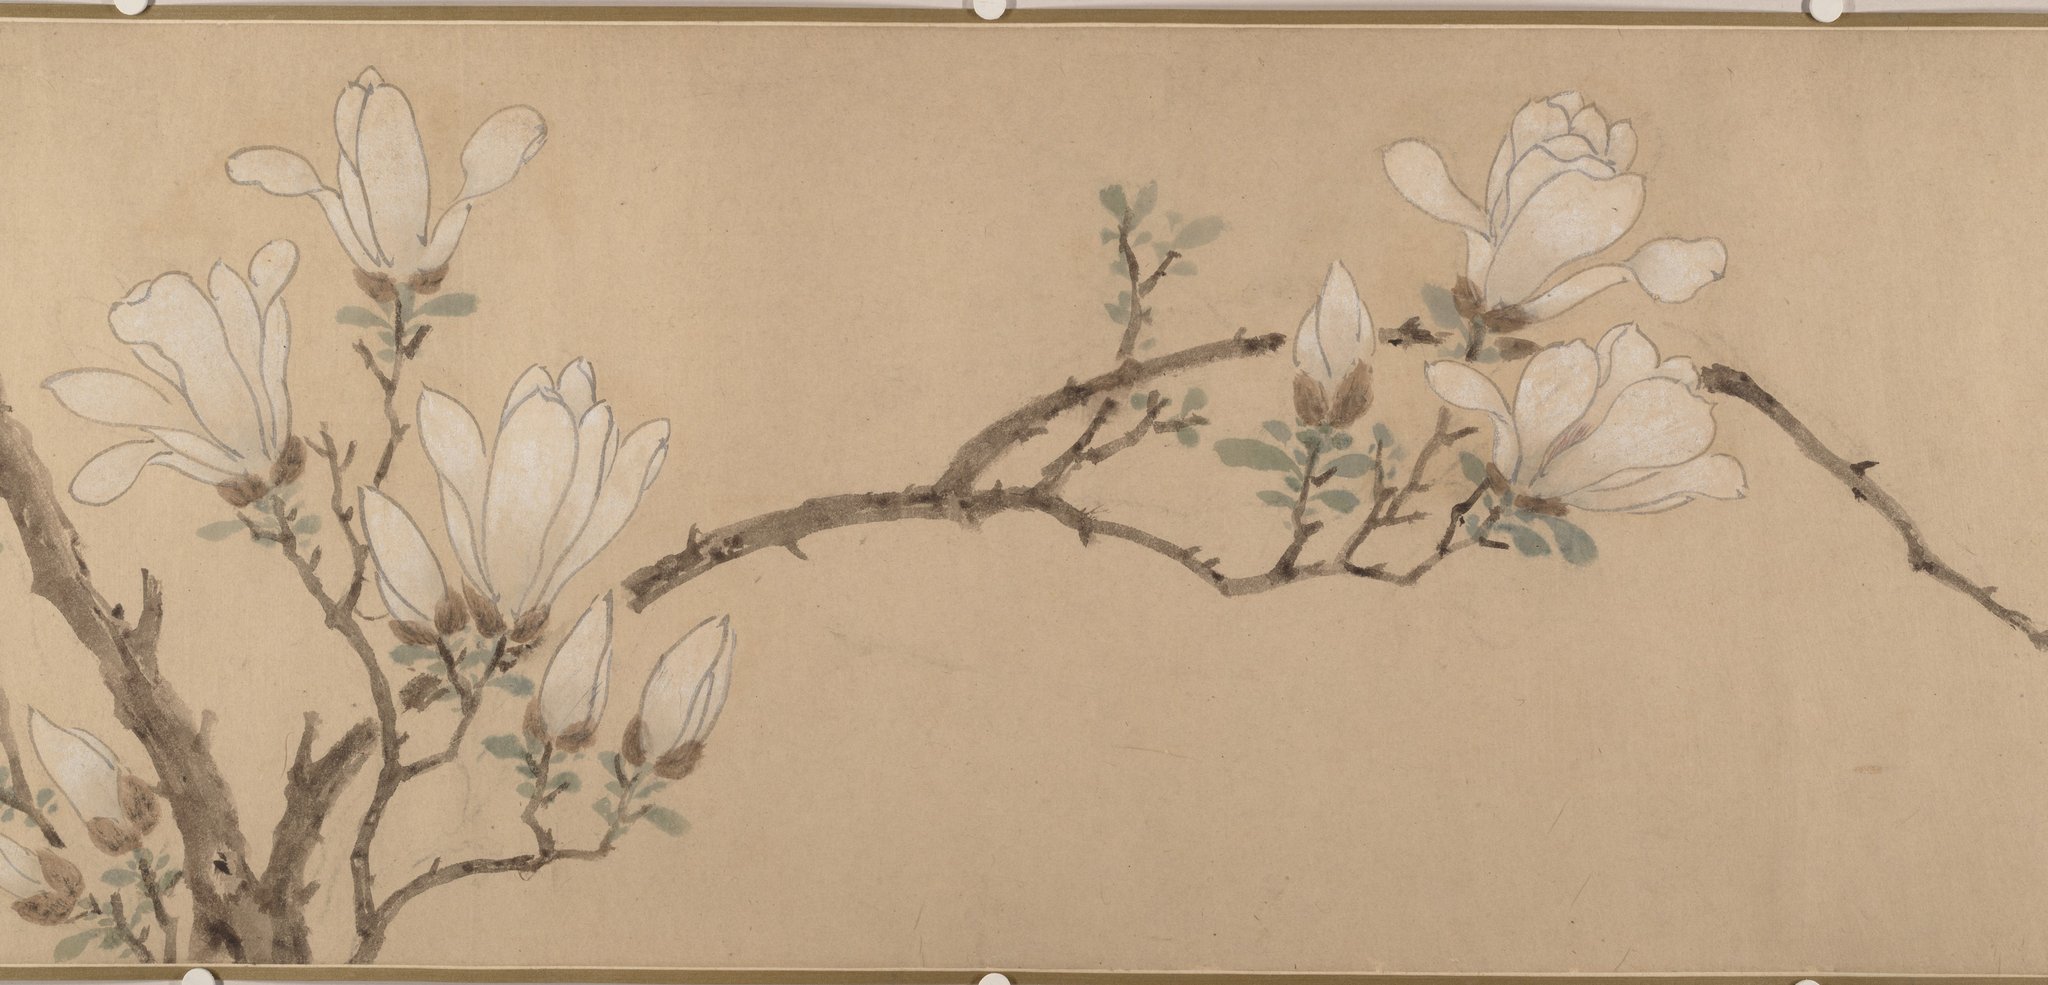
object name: handscroll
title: Magnolia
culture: chinese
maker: unidentified artist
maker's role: artist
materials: paper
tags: flowers